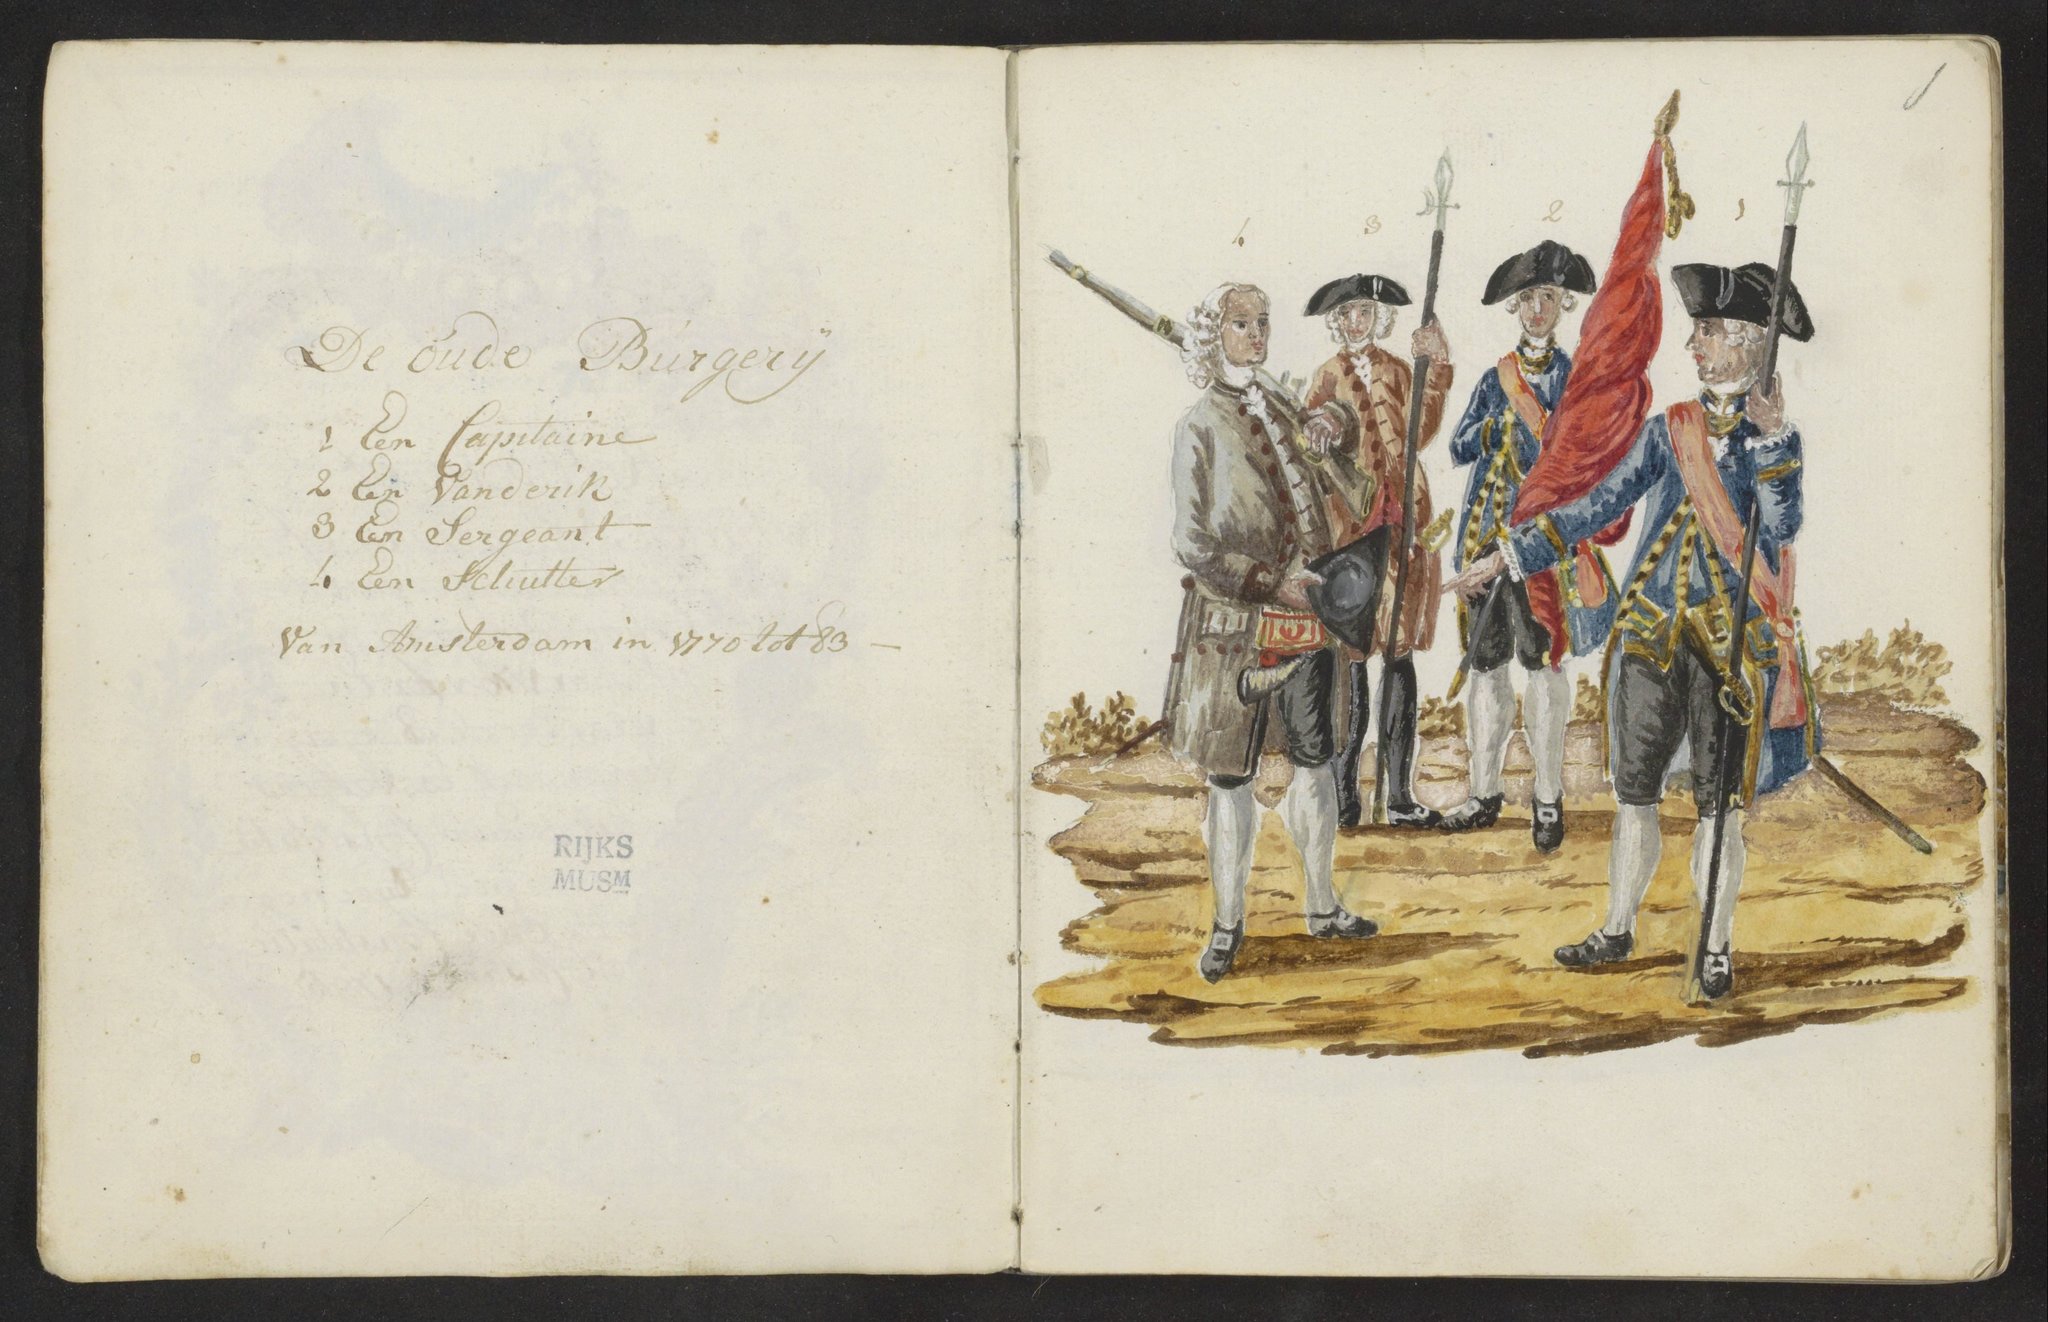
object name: drawing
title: De Oude Burgerij (...) van Amsterdam in 1770 tot 83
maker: s.g. casten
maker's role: draughtsman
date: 1795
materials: paper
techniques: writing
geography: amsterdam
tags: (military) uniforms (+ citizen soldiery, civil guard, citizen militia), patriots (1780-1795)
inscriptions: collector's mark: Lugt 2166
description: De uniformen van een kapitein, vaandrig, sergeant en schutter van de oude Amsterdamse schutterij. Onderdeel van het hoofdstuk over de oude Amsterdamse schutterij van 1770-1783. In het schetsboek met gekleurde tekeningen van de uniformen van militairen en leden van de schutterij uit de periode 1770 tot 1795-1796.